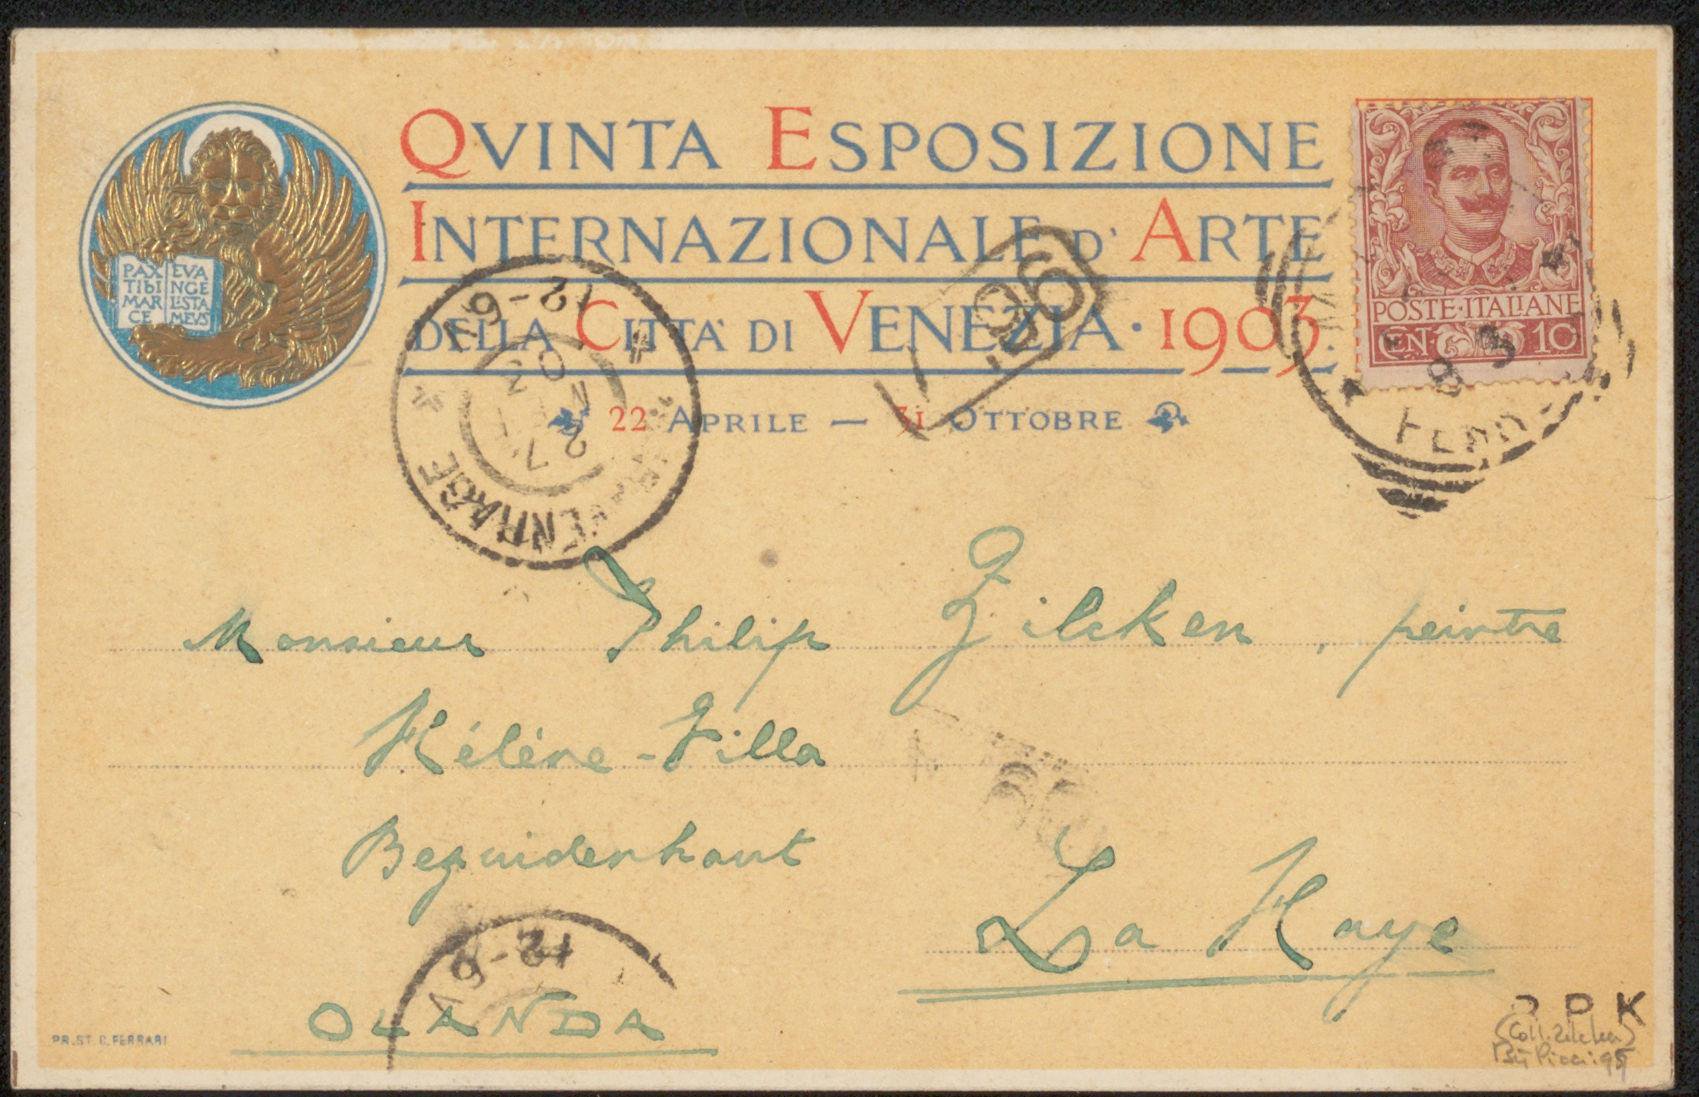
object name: postcard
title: Briefkaart aan Philip Zilcken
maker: vittorio pica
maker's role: criticus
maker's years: 1864-1930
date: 1903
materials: cardboard, ink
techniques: pen, writing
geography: milan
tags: the hague, painter, print maker, draughtsman, jozef israëls, philip zilcken, travelling; tourism, painting (including book-illumination, miniature-painting), money, venice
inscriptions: collector's mark: ‘RPK’